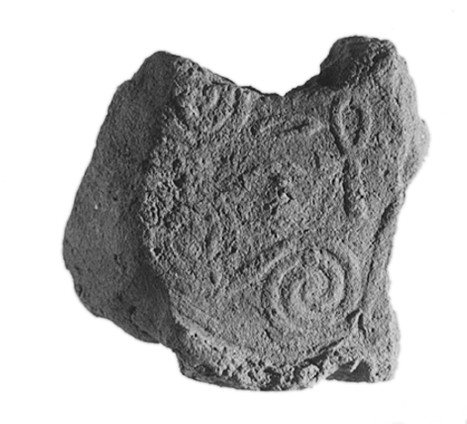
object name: sealing, administrative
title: Administrative Seal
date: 1981-1640 BCE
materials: clay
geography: egypt